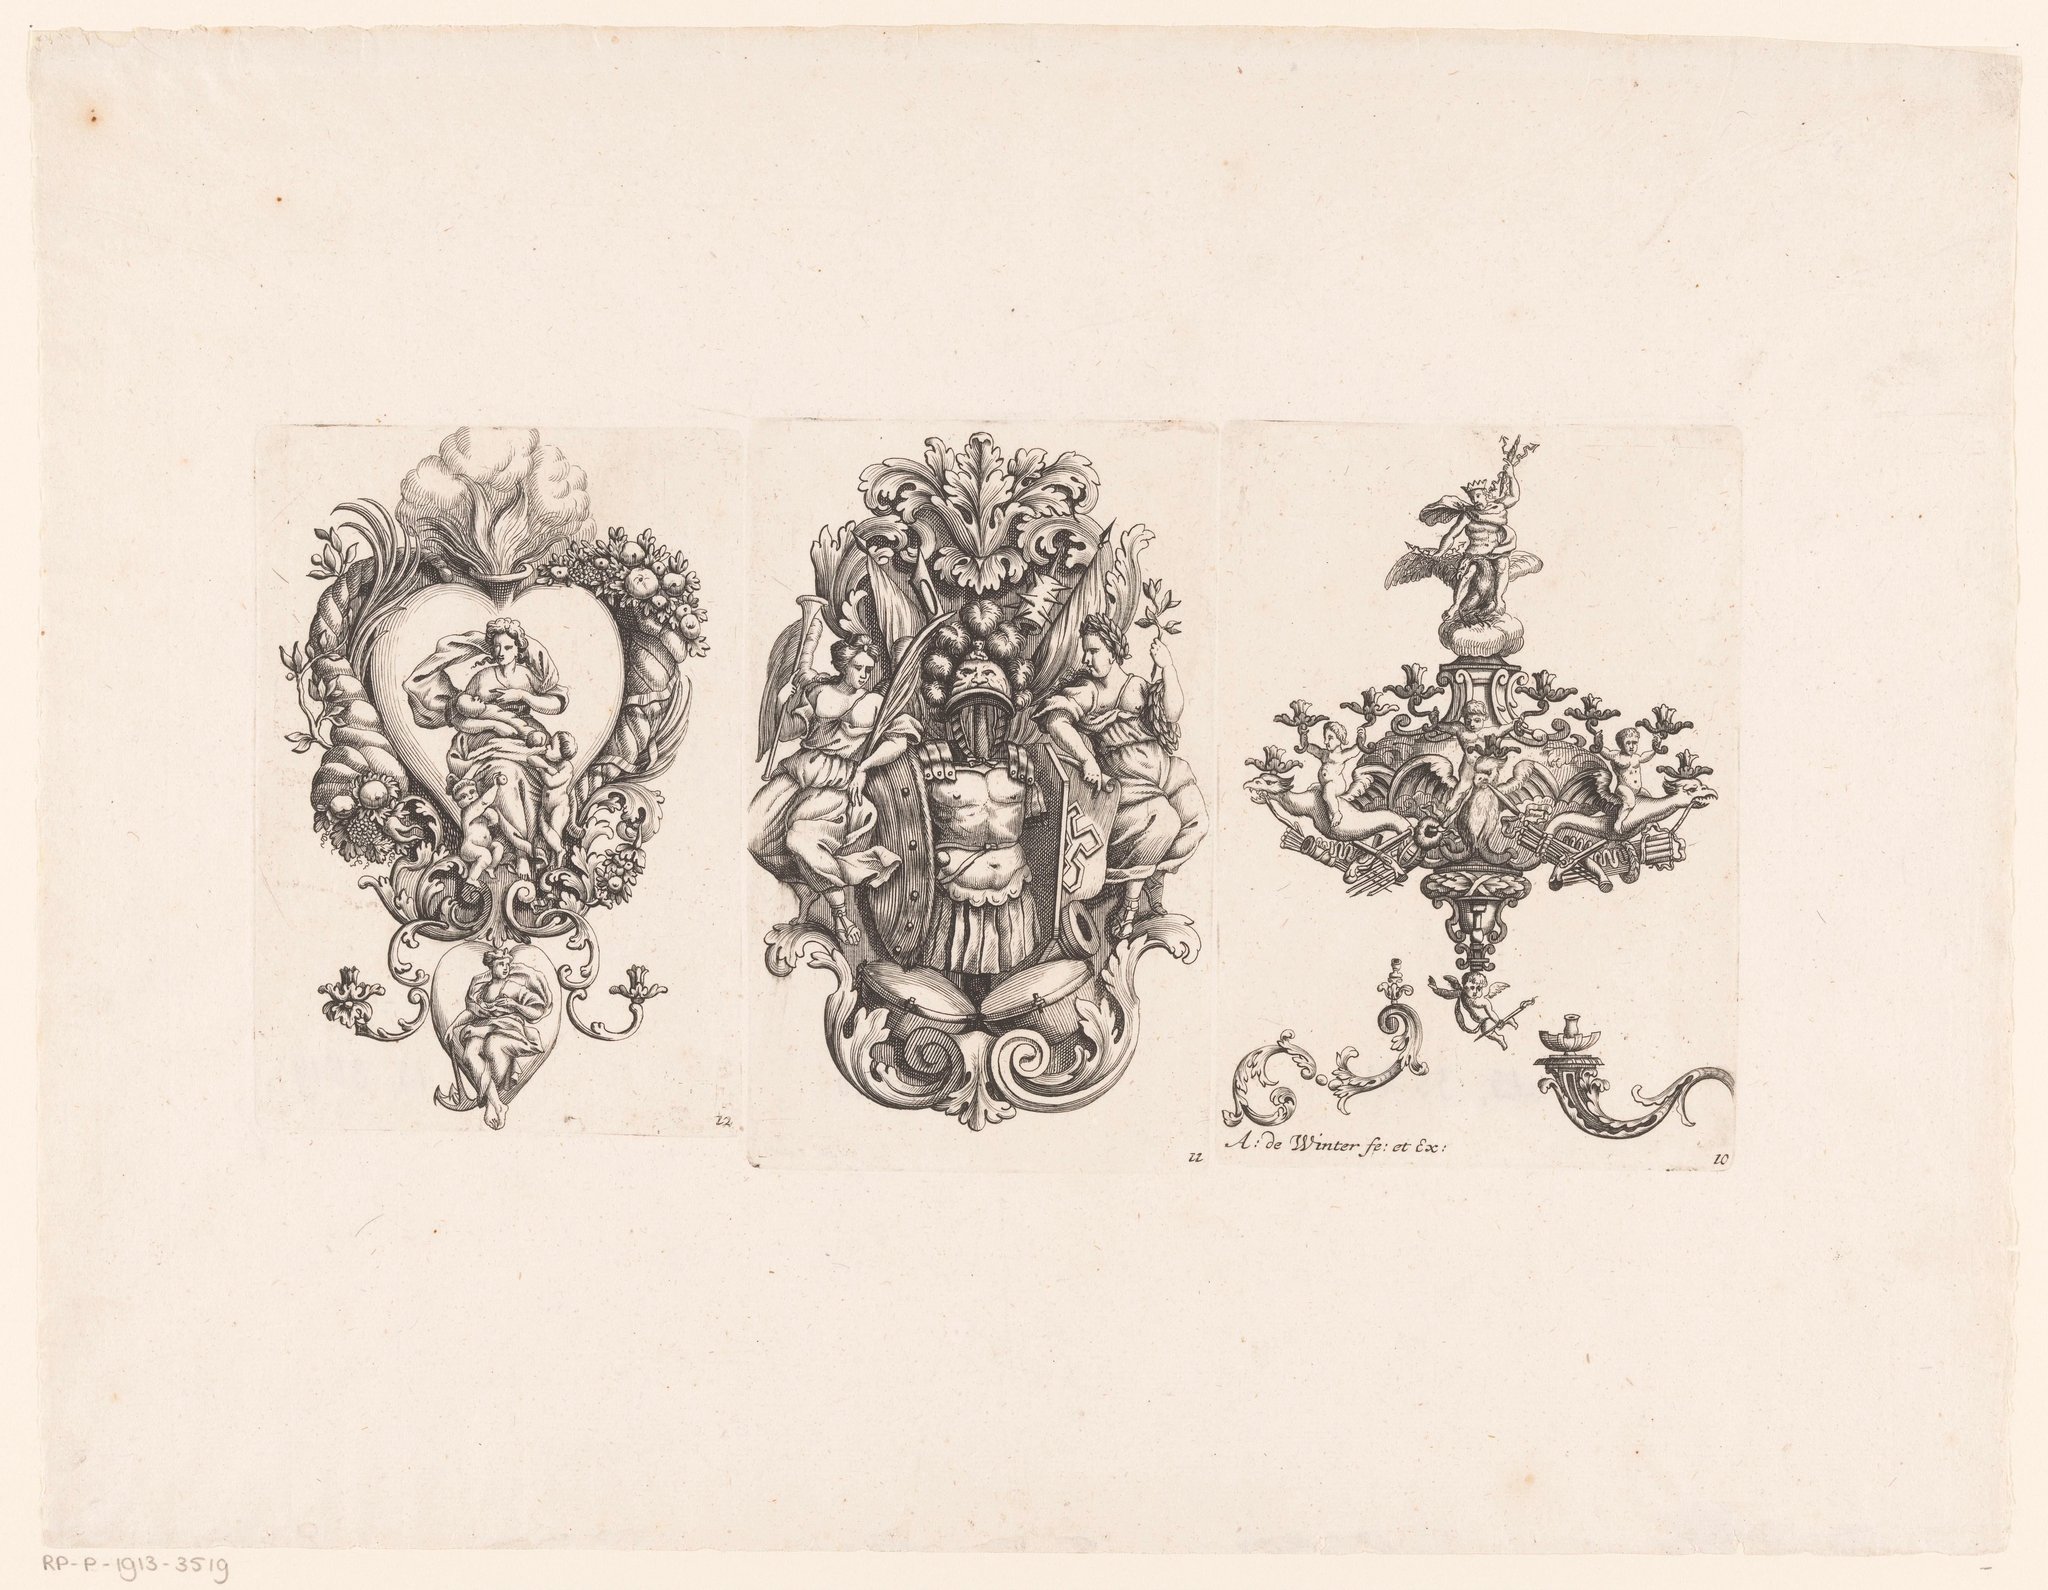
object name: ornament print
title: Wandkandelaars met Caritas, een harnas en Jupiter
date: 1696-1717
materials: paper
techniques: engraving, etching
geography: amsterdam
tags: charity, 'caritas'; 'carità' (ripa) ~ one of the three theological virtues, chandelier, candelabrum, (story of) jupiter (zeus), armour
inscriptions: collector's mark: Lugt 2228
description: Drie prenten op een blad. Links: Een tweearmige wandkandelaar met Charitas en Hoop. Midden: Een wandkandelaar met een harnas omringd door wapens, een engel en een gelauwerde figuur. Rechts: Een tweearmige wandkandelaar met putti op draken en Jupiter op een adelaar.